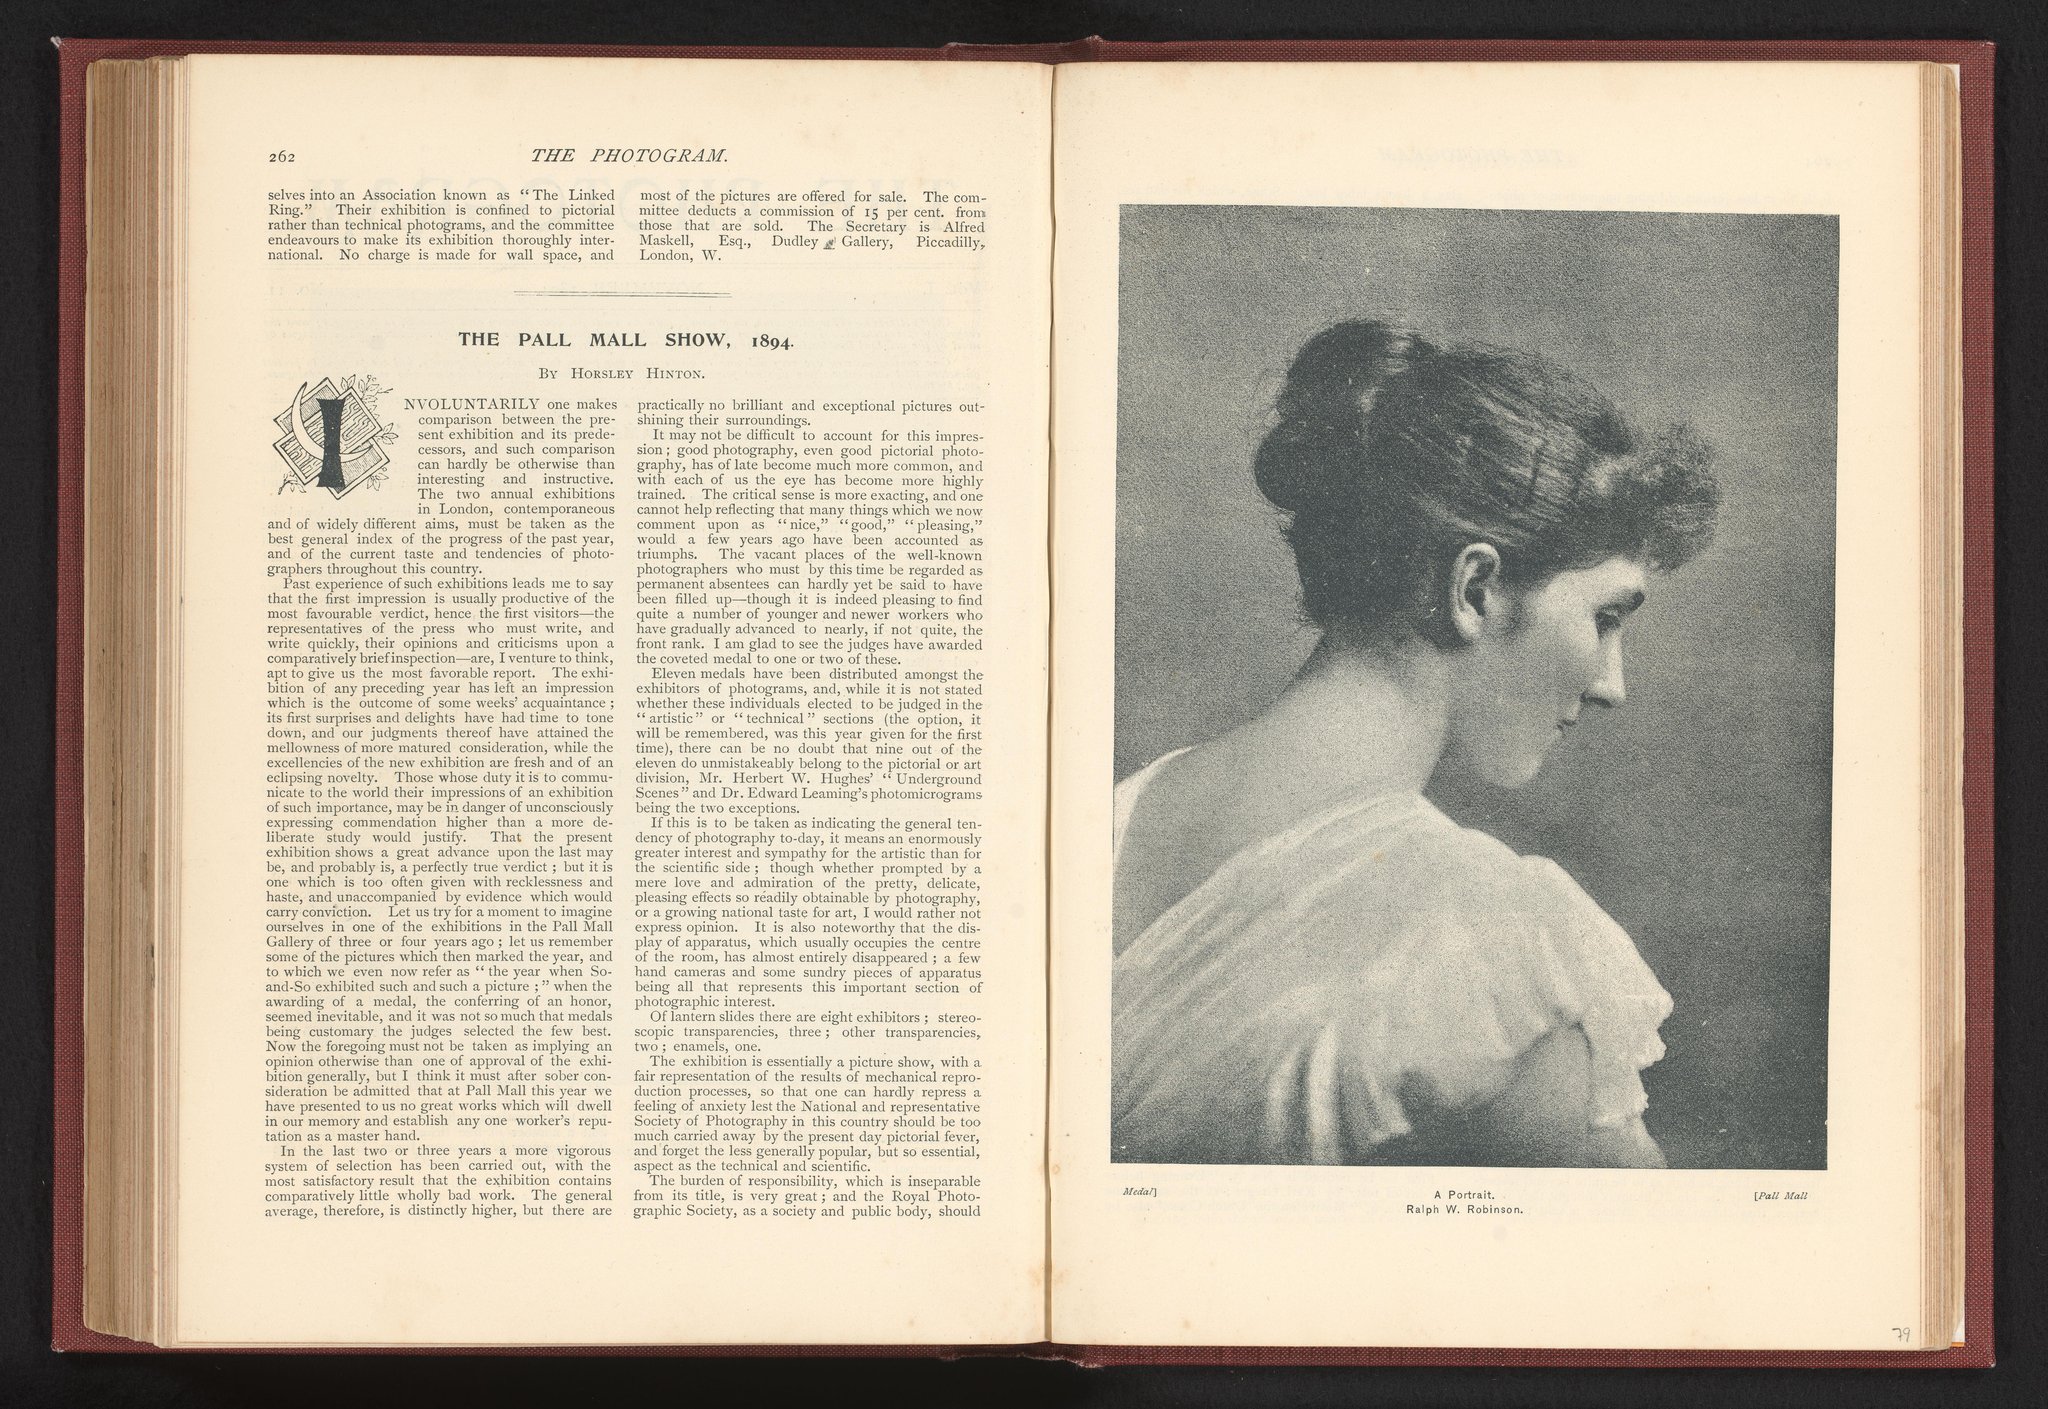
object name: photomechanical print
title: A portrait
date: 1889-1894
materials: paper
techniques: autotype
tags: historical persons - bb - woman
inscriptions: inscription: ‘Medal/ Pall Mall’